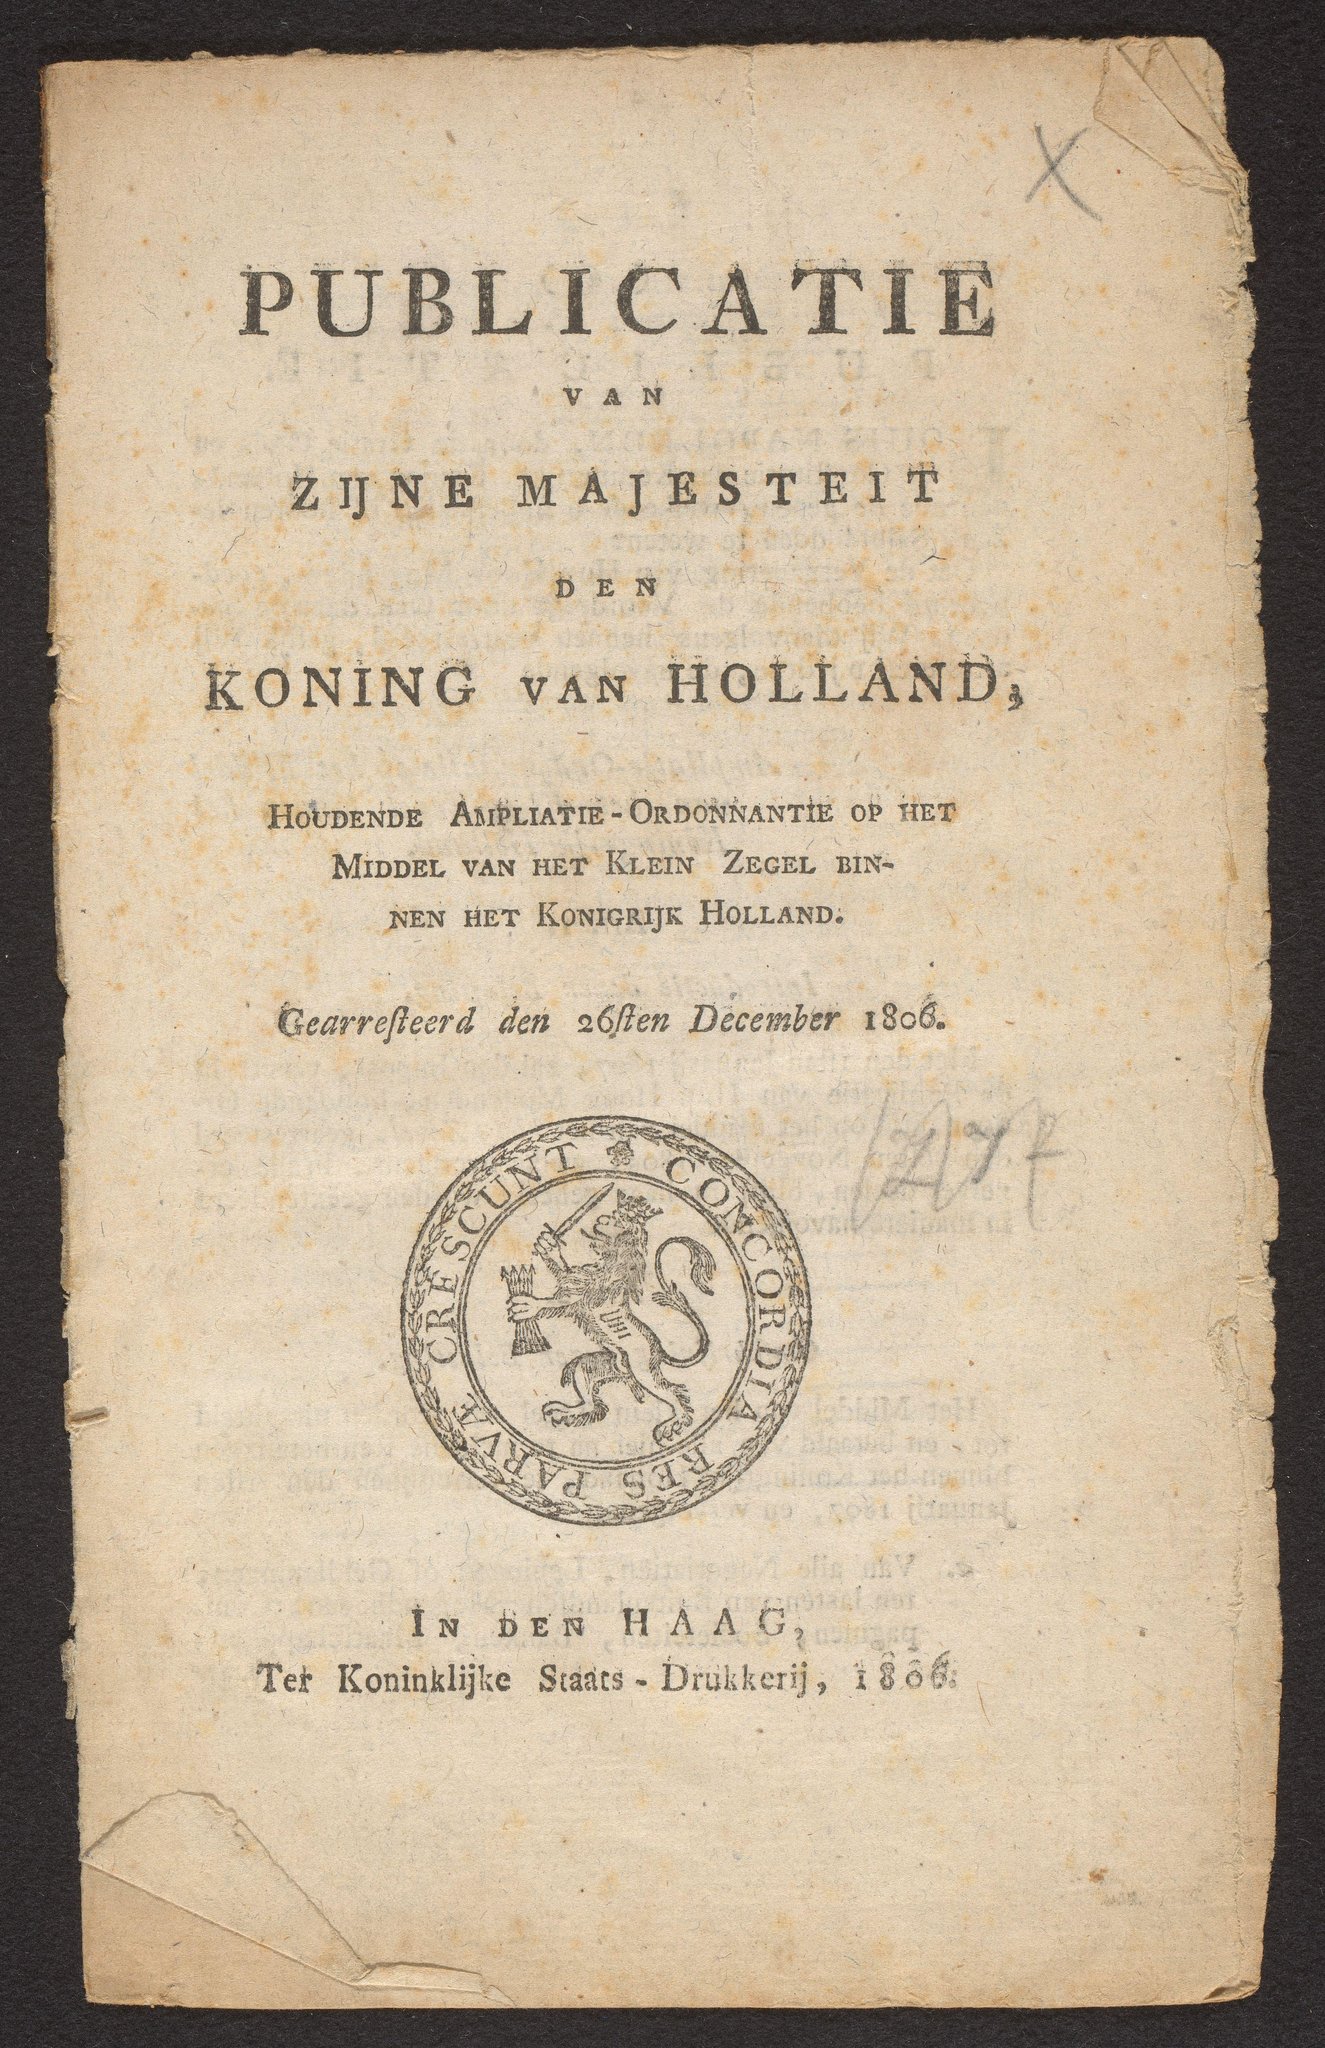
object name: brochure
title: Publicatie van zijne majesteit den Koning van Holland, houdende ampliatie-ordonnantie op het middel van het Klein Zegel binnen het Konigryk Holland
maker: louis napoleon (king of holland)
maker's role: koning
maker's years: 1778-1846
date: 1806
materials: paper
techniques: printing, sewing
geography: the hague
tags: netherlands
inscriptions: date